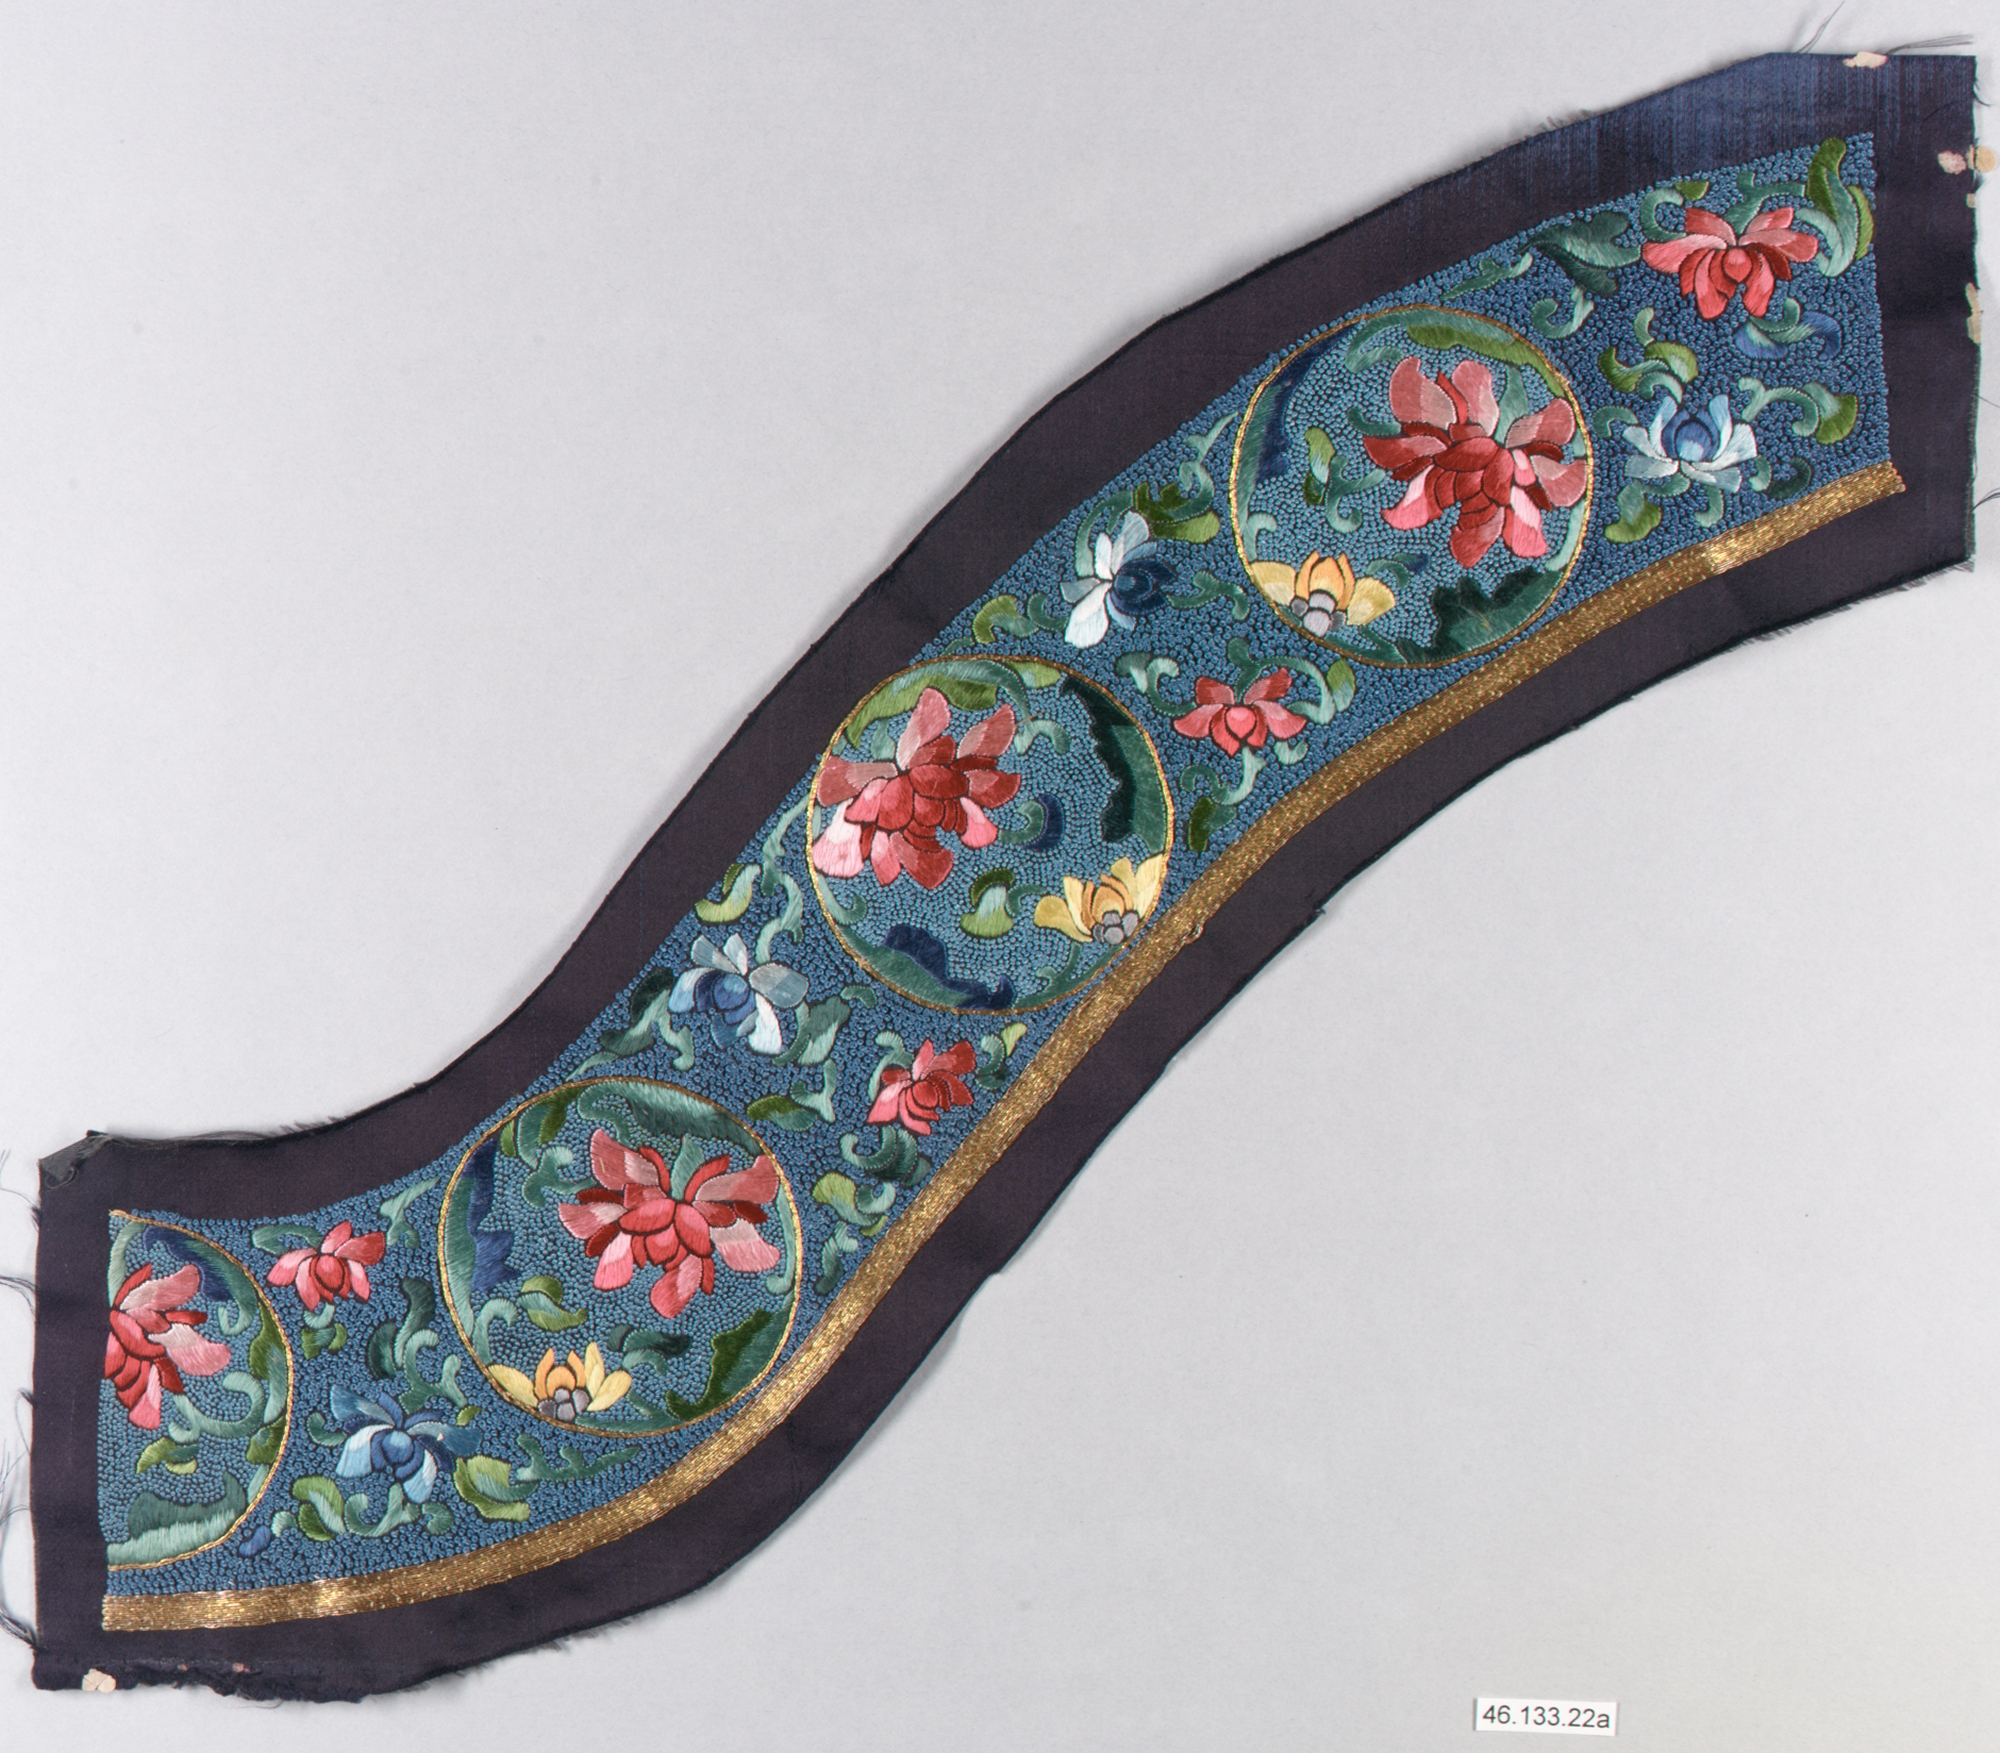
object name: collar and yoke section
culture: chinese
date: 1767-1800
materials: metal thread, silk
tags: flowers